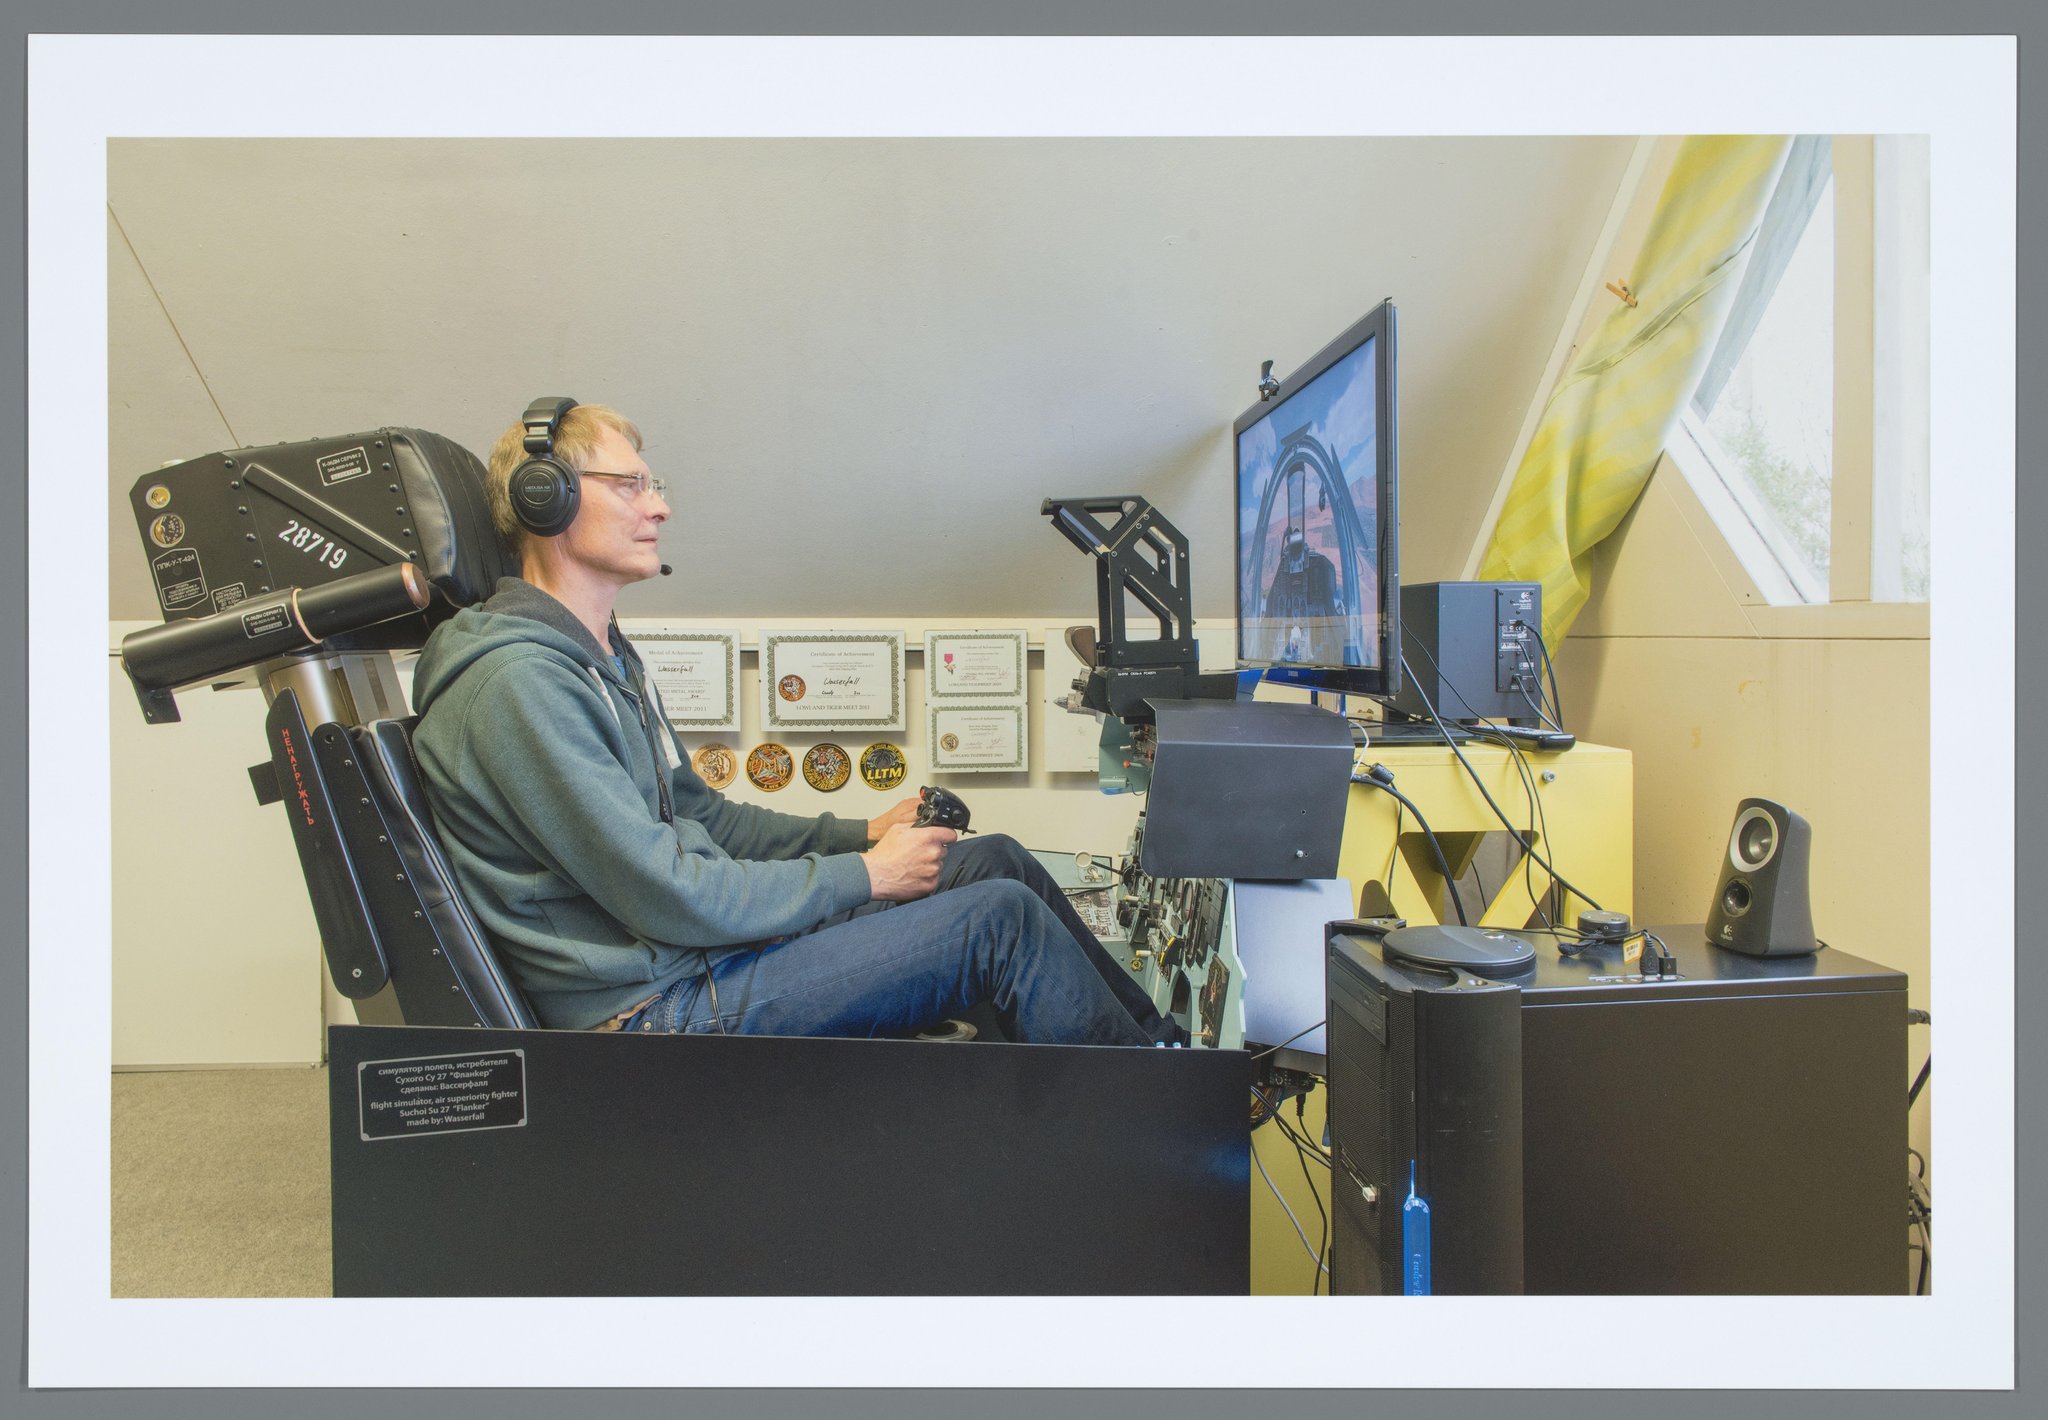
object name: photograph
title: Henry (57)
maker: gerrit meerman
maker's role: fotograaf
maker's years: 1957-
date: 2017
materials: ink, paper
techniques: inkjet print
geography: netherlands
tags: airborne traffic, aviation, computer, equation-solving machine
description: “Het is niet in uren uit te drukken hoeveel tijd in het bouwen is gaan zitten”. Toen Henry begin jaren 90 op zijn computer kennismaakte met de SU-27 Flanker, was hij meteen verkocht. De eenvoudige scenery van de Krim gaf hem al een aardige beleving van het vliegen. Na het zien van een echte Russische SU-27 tijdens een airshow, ontstond het verlangen om de cockpit van dit type toestel zo realistisch mogelijk na te bouwen. Een vriend die in Azië een piloot in de familie had, leverde foto’s van de cockpit met een meegefotografeerde rolmaat. Zo konden de juiste maten van de instrumenten in de cockpit herleid worden. Nu is alles schaal 1:1 nagebouwd en voorzien van Russische teksten en tekens. De onderdelen die nog niet nagemaakt zijn, zijn in fotoprint uitgevoerd om de ‘look’ te vervolmaken. Elke dinsdagavond vliegt Henry online met zijn maten van het Dutch Flanker Displayteam. Zijn bijnaam is ‘Wasserfall’, gebaseerd op de door de Duitsers tijdens WO II ontwikkelde raket.